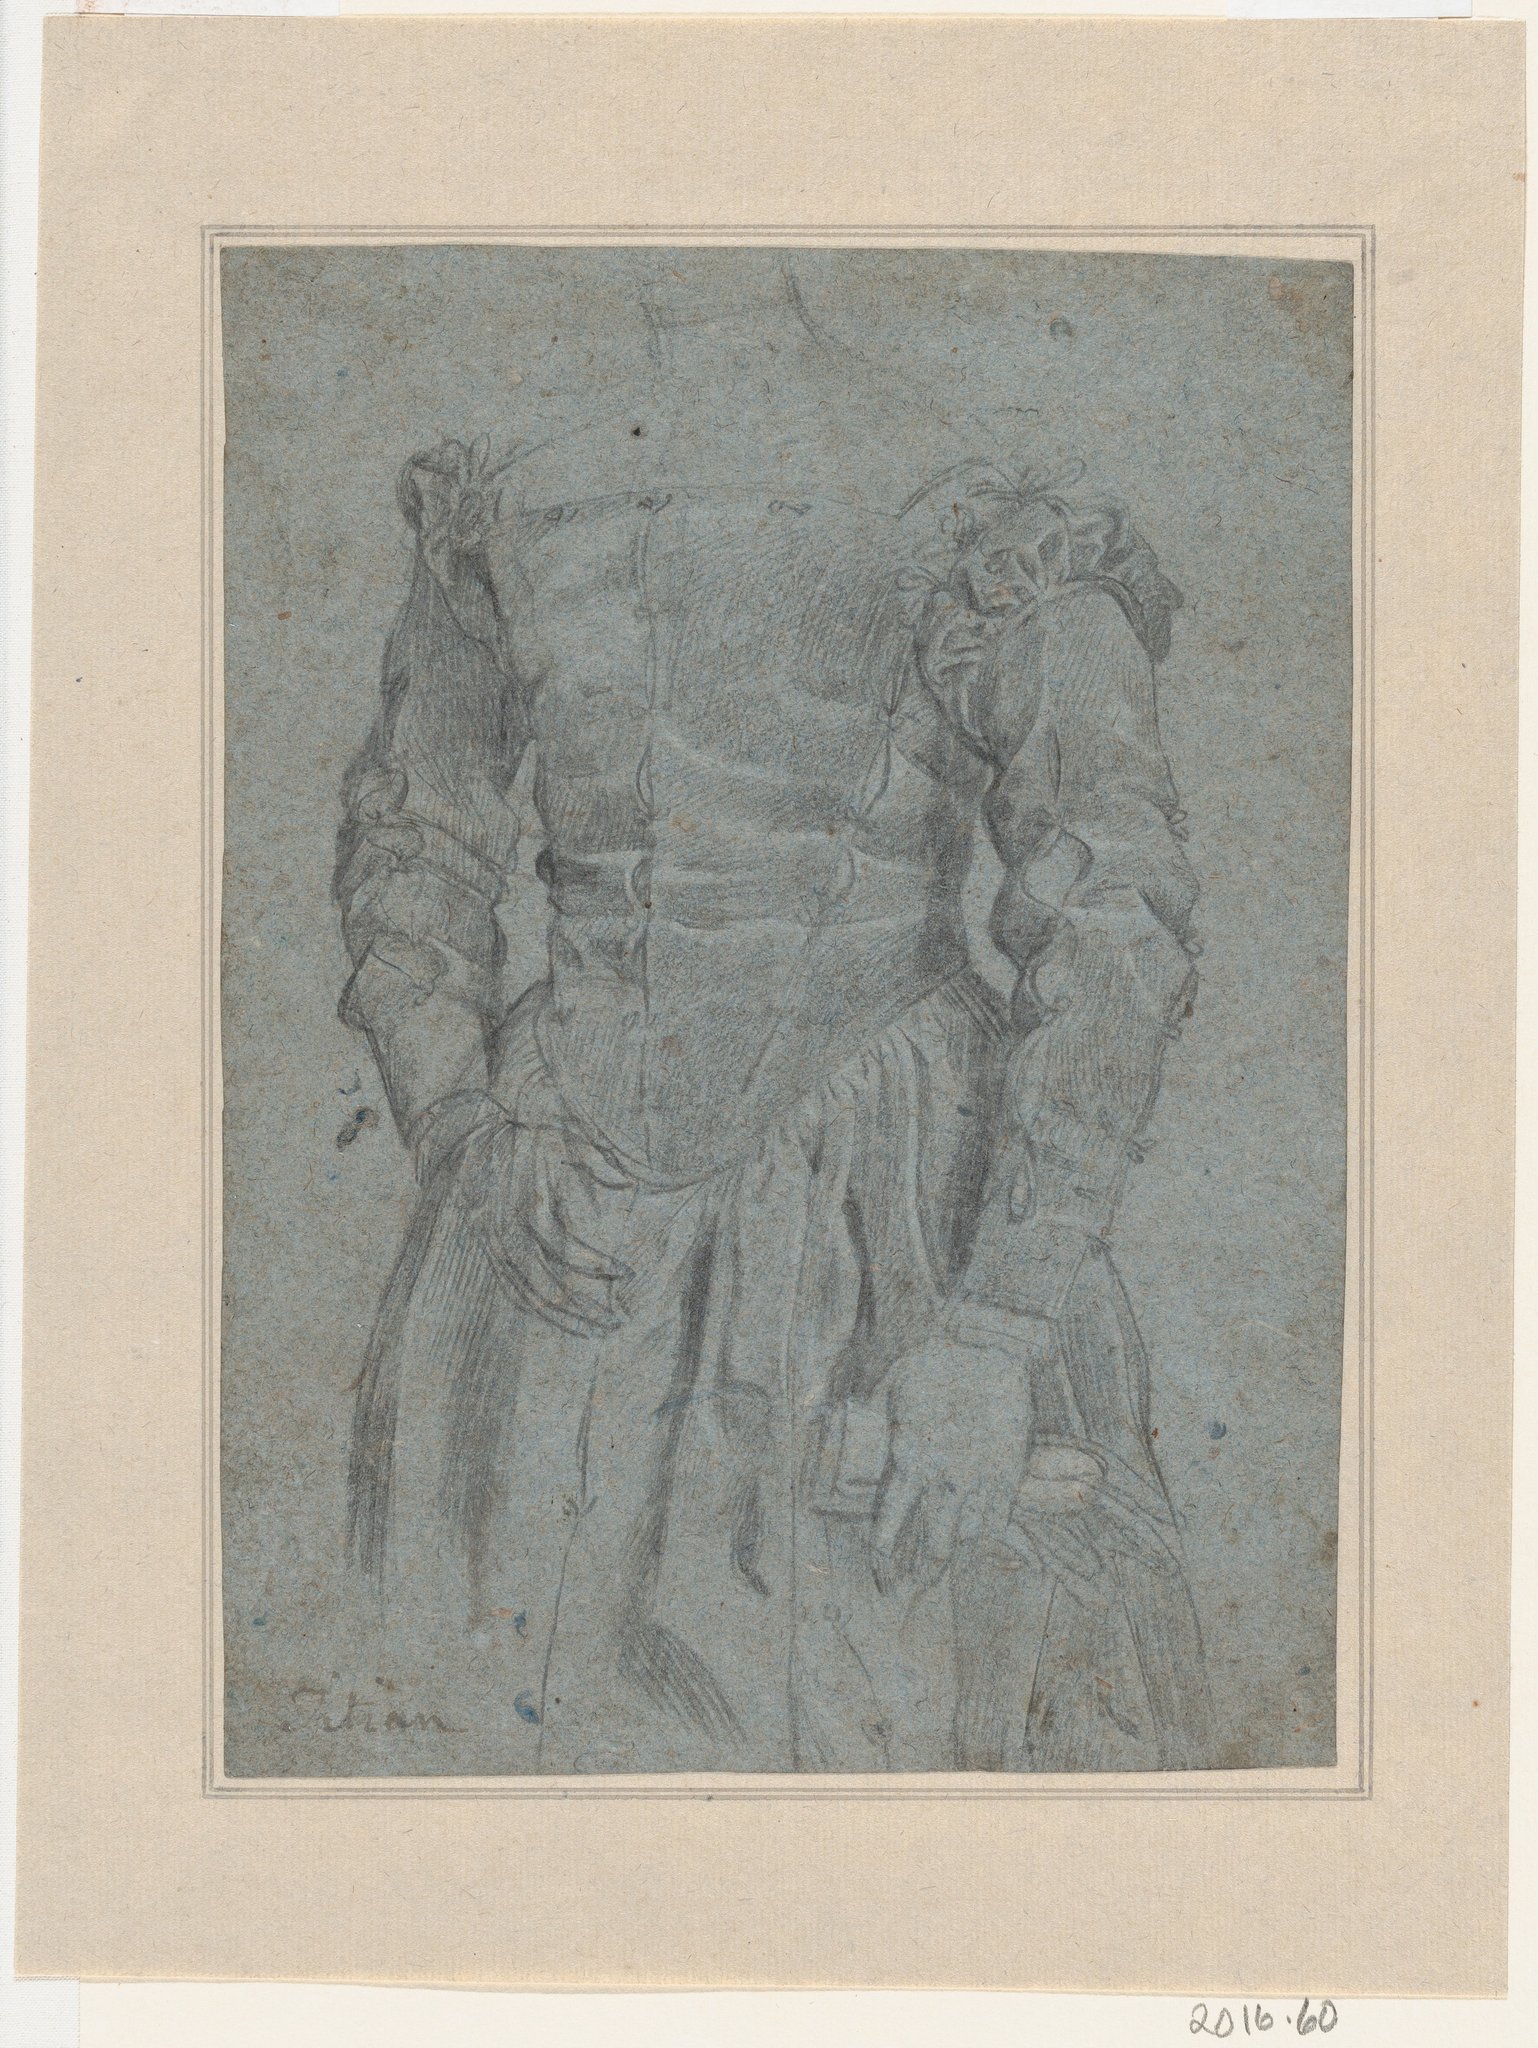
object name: drawing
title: Study of a Woman’s Dress for a Portrait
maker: anonymous, italian, venetian, 16th century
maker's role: artist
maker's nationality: italian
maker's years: 1500-1600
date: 1540-1560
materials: chalk, paper